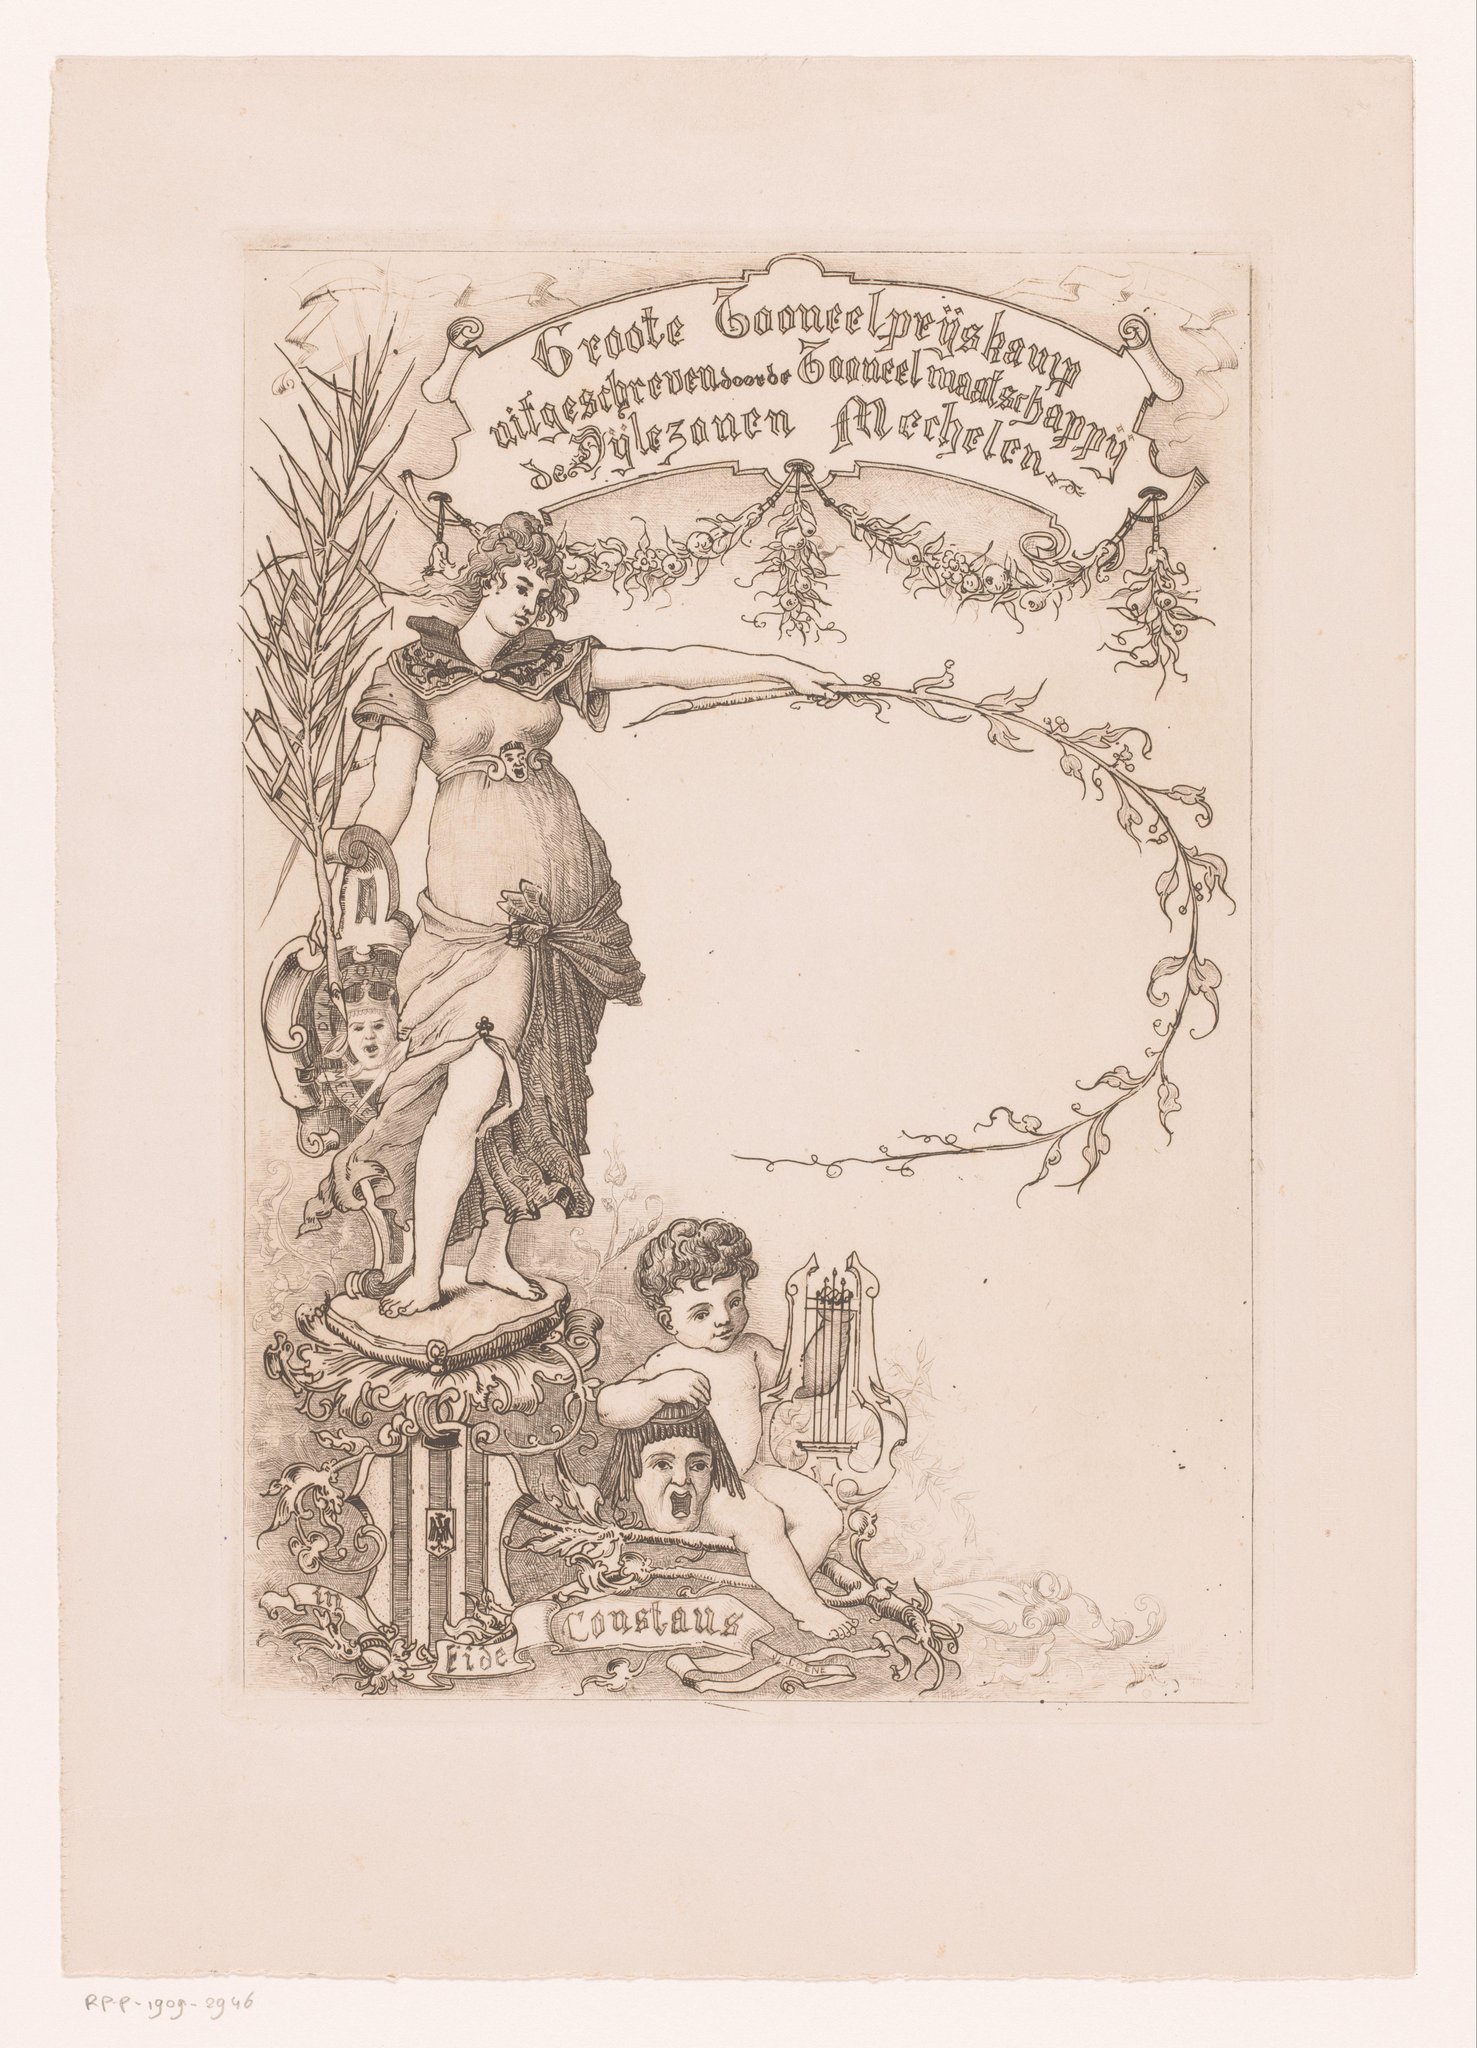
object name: print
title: Diploma van Tooneelmaatschappij de Dijlezonen te Mechelen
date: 1815-1909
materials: paper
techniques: etching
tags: mask, ornament ~ festoon, garland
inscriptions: collector's mark: Lugt 2228, stamp: ‘Sainte Marie’